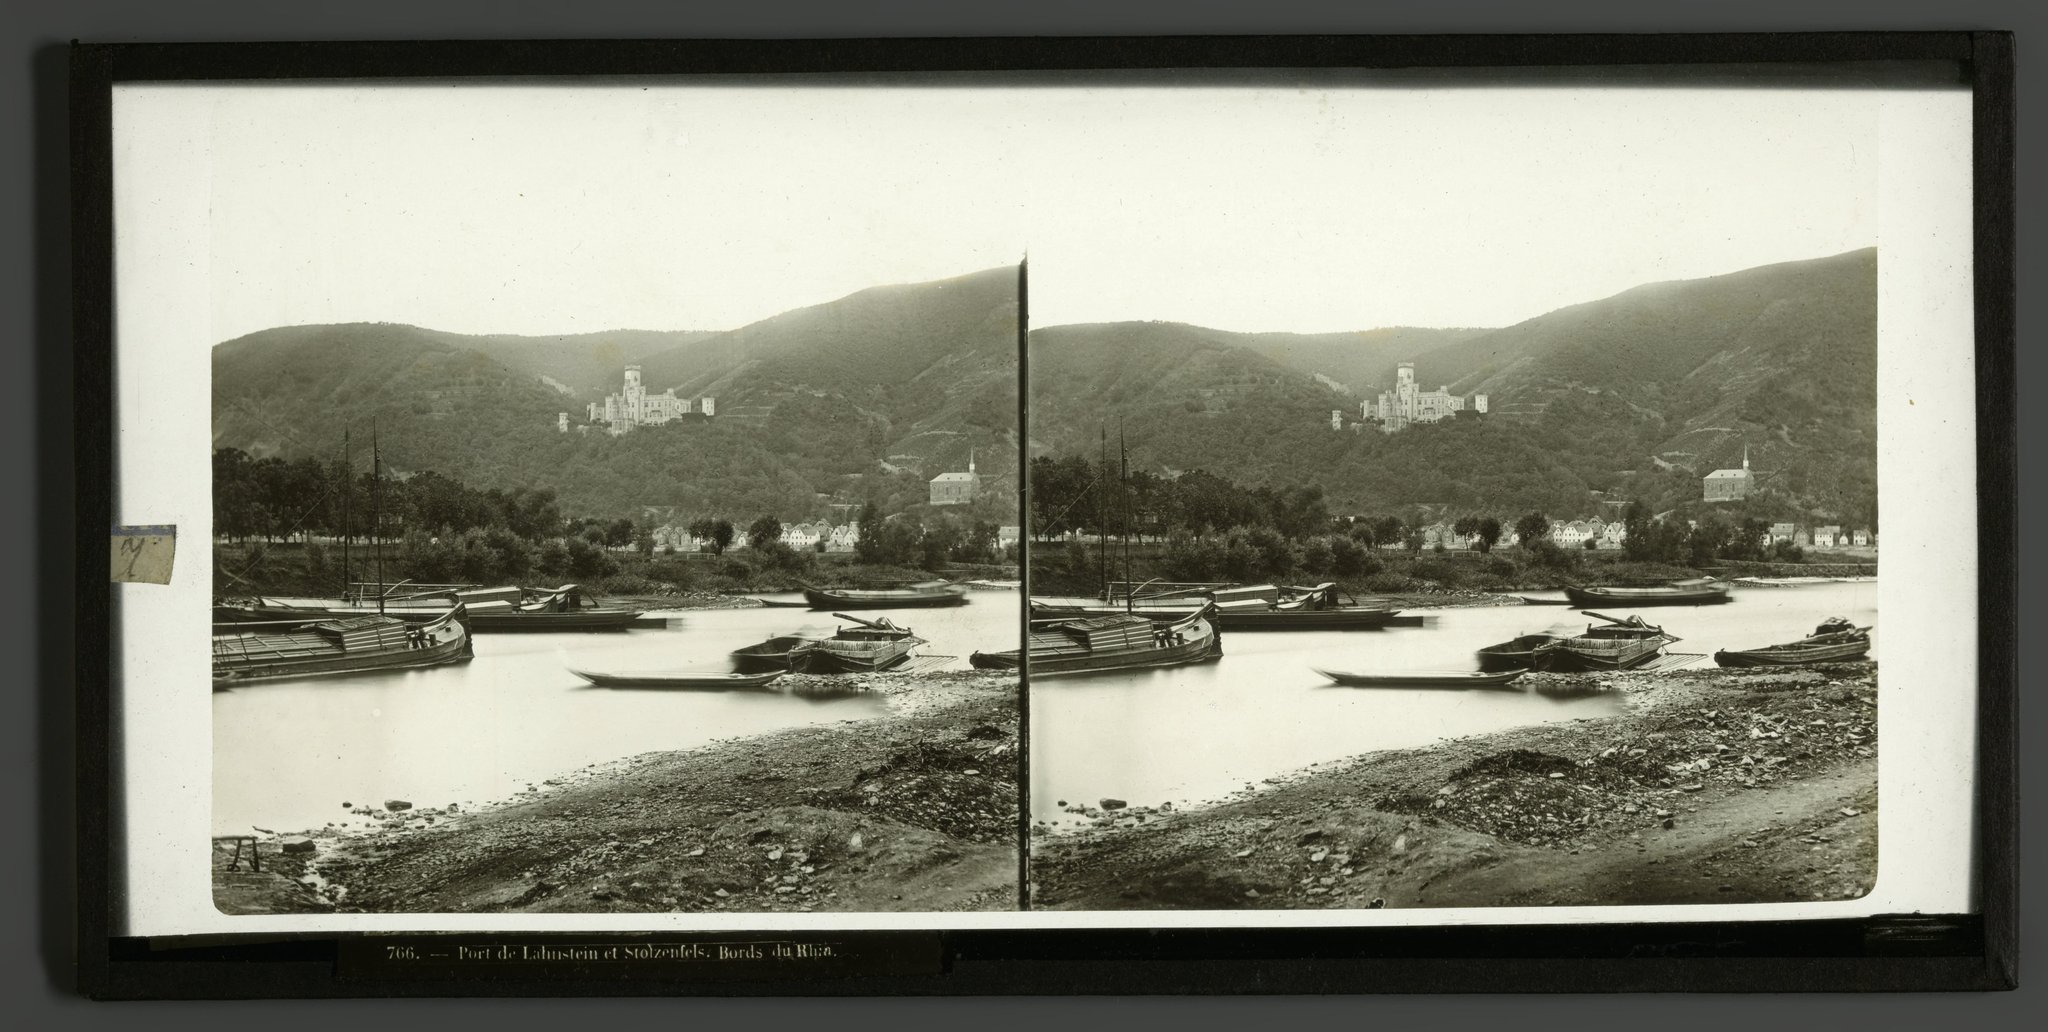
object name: stereoscopic photograph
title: Port de Lahnstein et Stolzenfels, Bords du Rhin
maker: ferrier père-fils et soulier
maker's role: publisher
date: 1860-1890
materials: glass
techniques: slide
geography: koblenz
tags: castle, river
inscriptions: number: ‘766.’